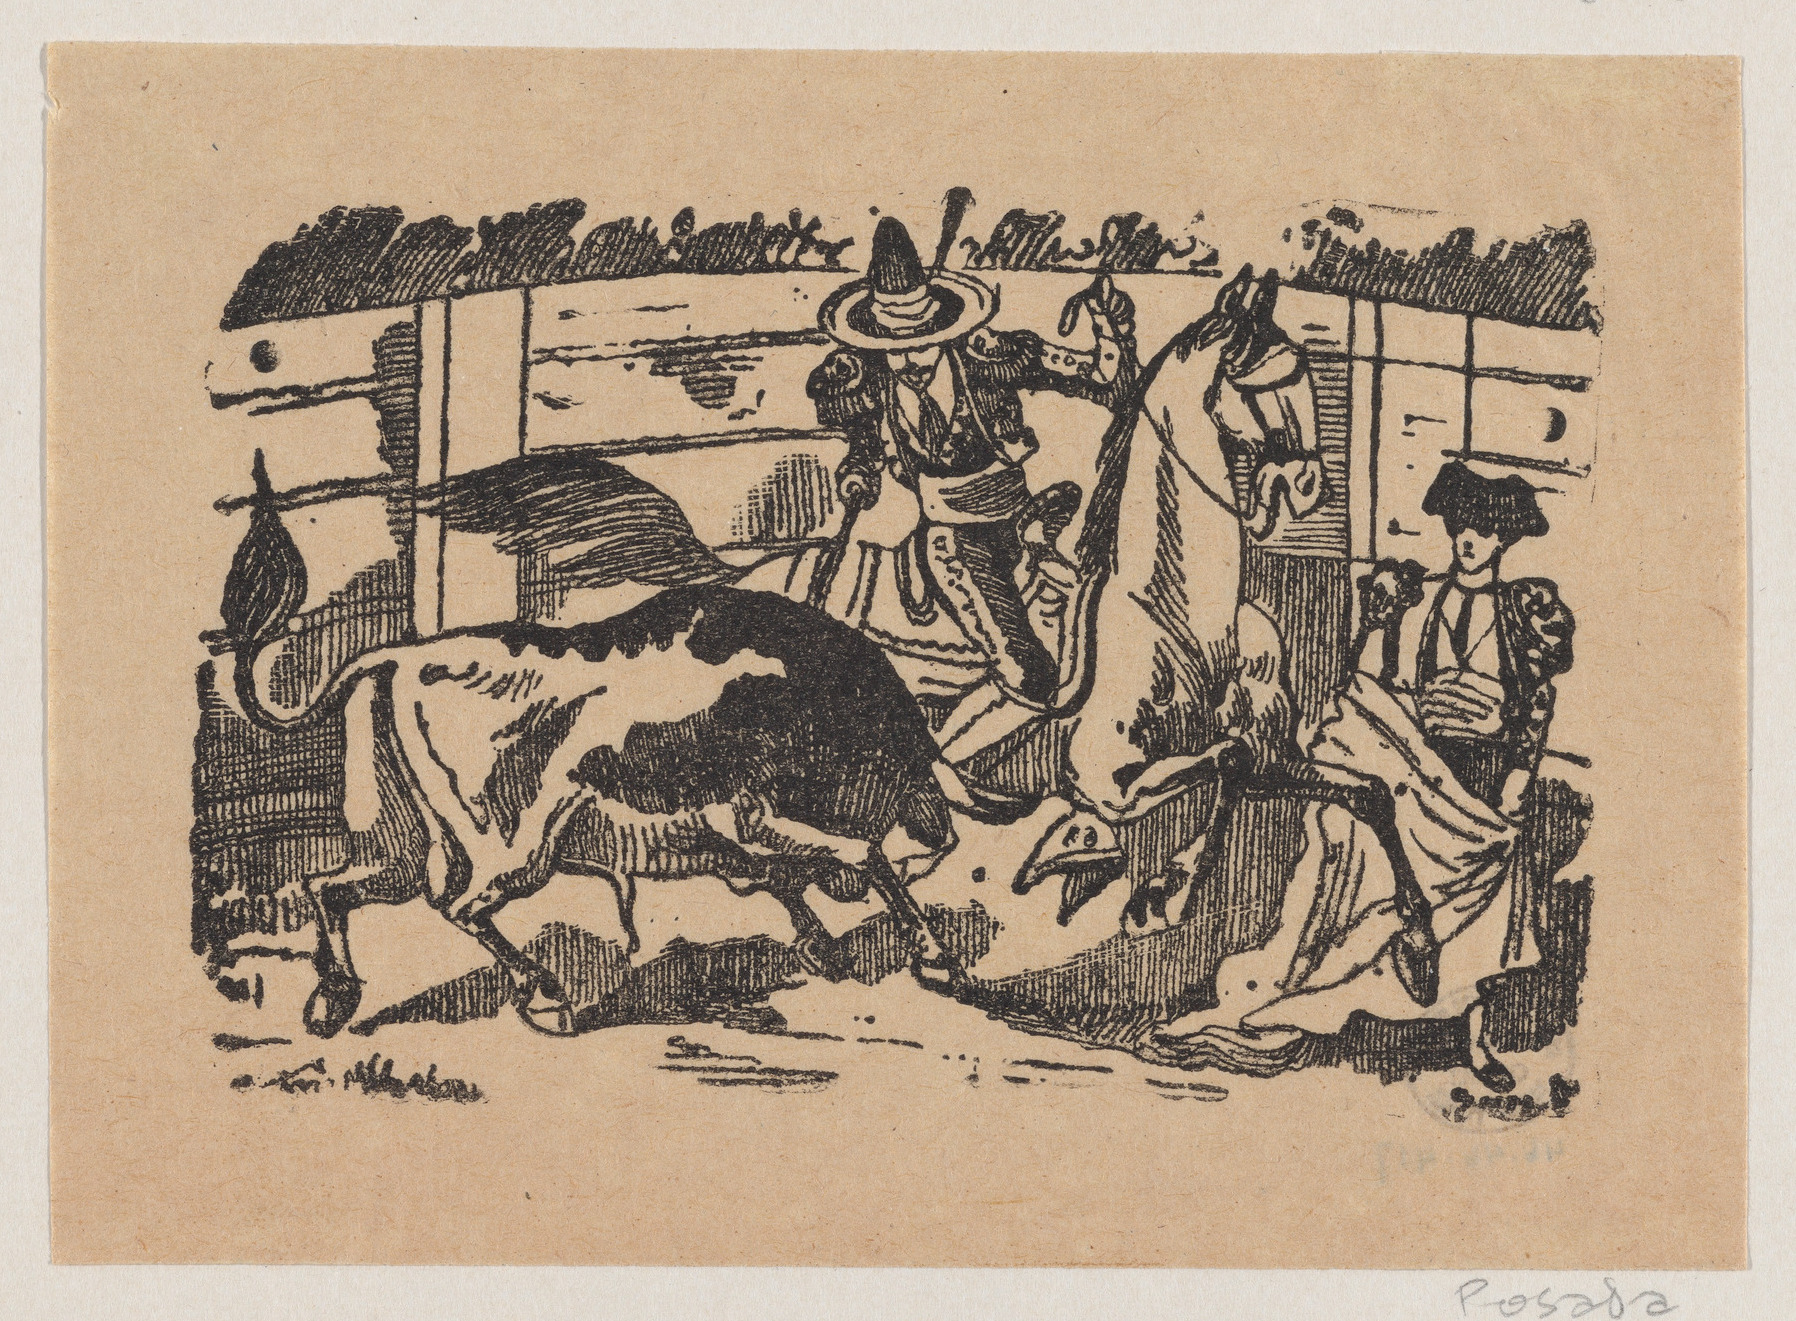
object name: print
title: A picador on horseback stabbing a bull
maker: josé guadalupe posada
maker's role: artist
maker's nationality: mexican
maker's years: 1852-1913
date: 1890-1910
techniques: lithography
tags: men,bulls,horses